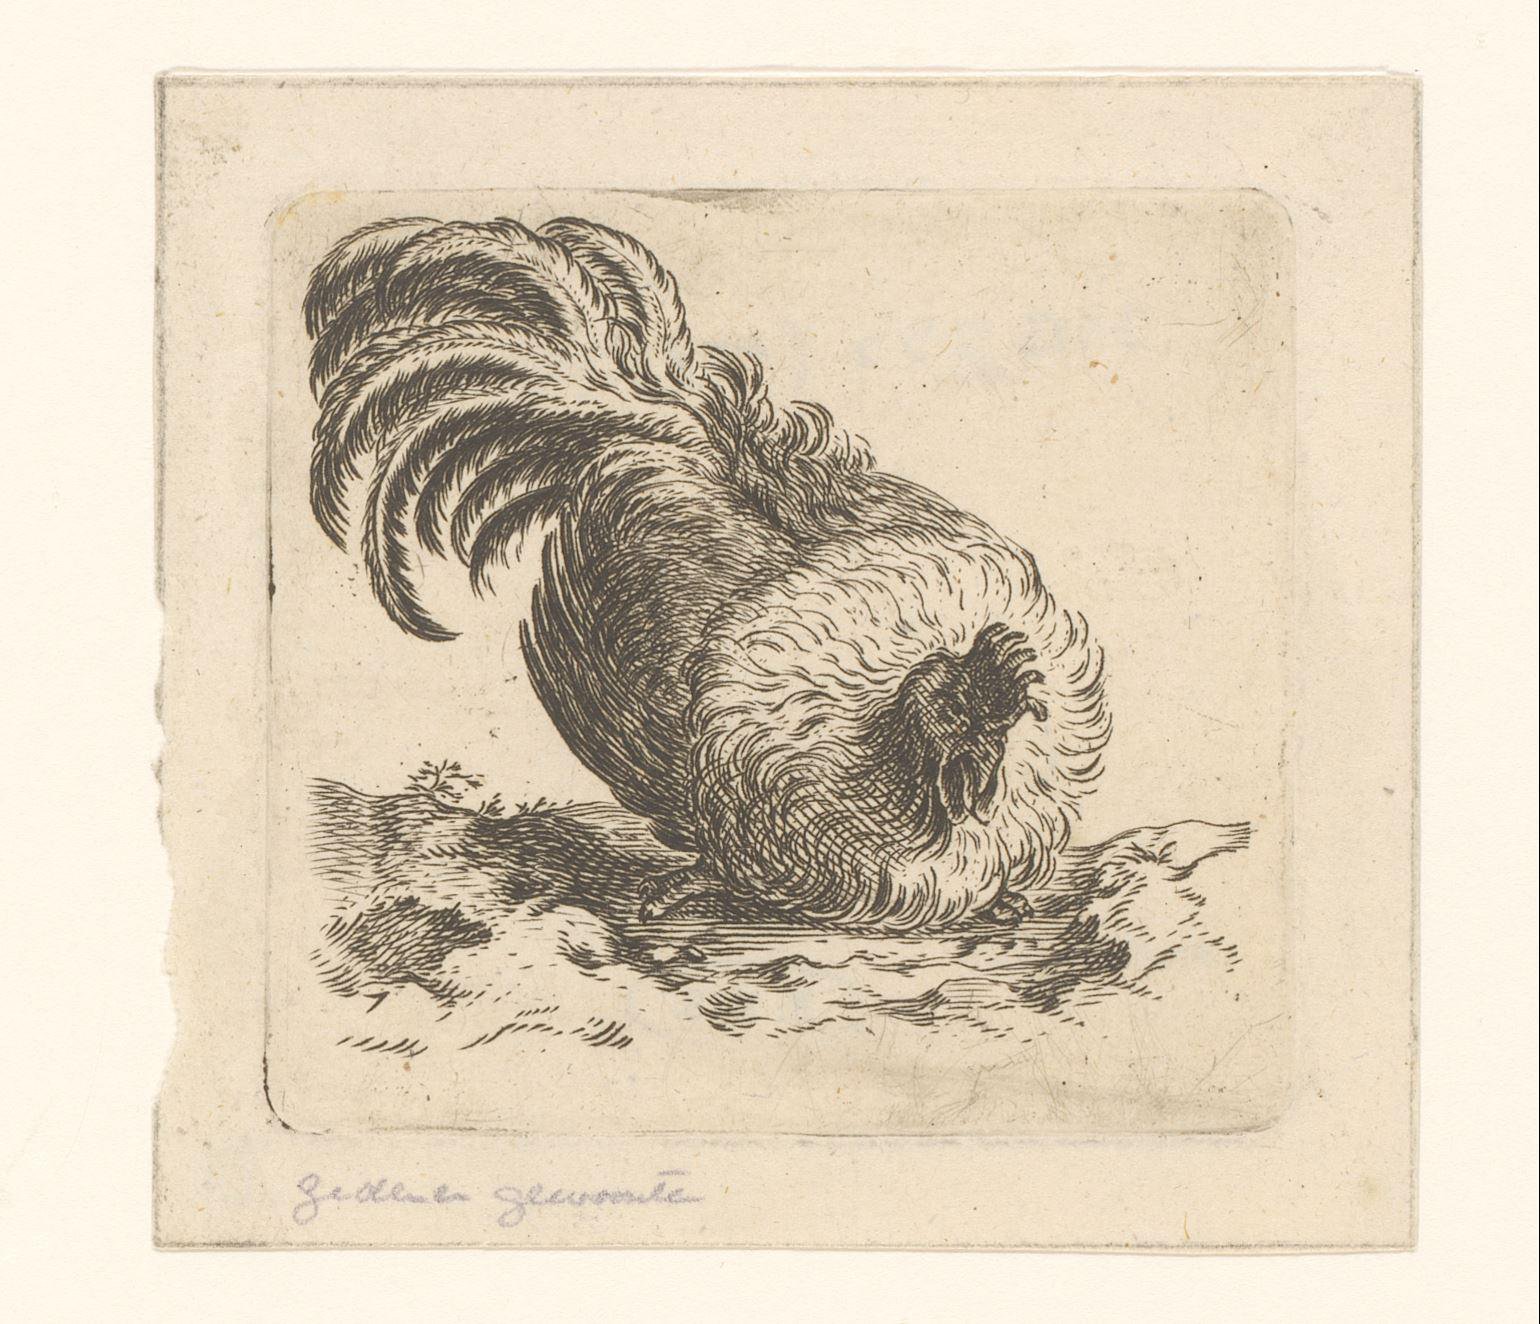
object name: print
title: Zittende haan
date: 1617-1681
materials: paper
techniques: etching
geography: amsterdam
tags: animals, fowl (cock, hen, chicken, etc.) (+ male animal)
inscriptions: collector's mark: Lugt 2228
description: Maakt deel uit van een twaalfdelige serie met boerderijbeesten.